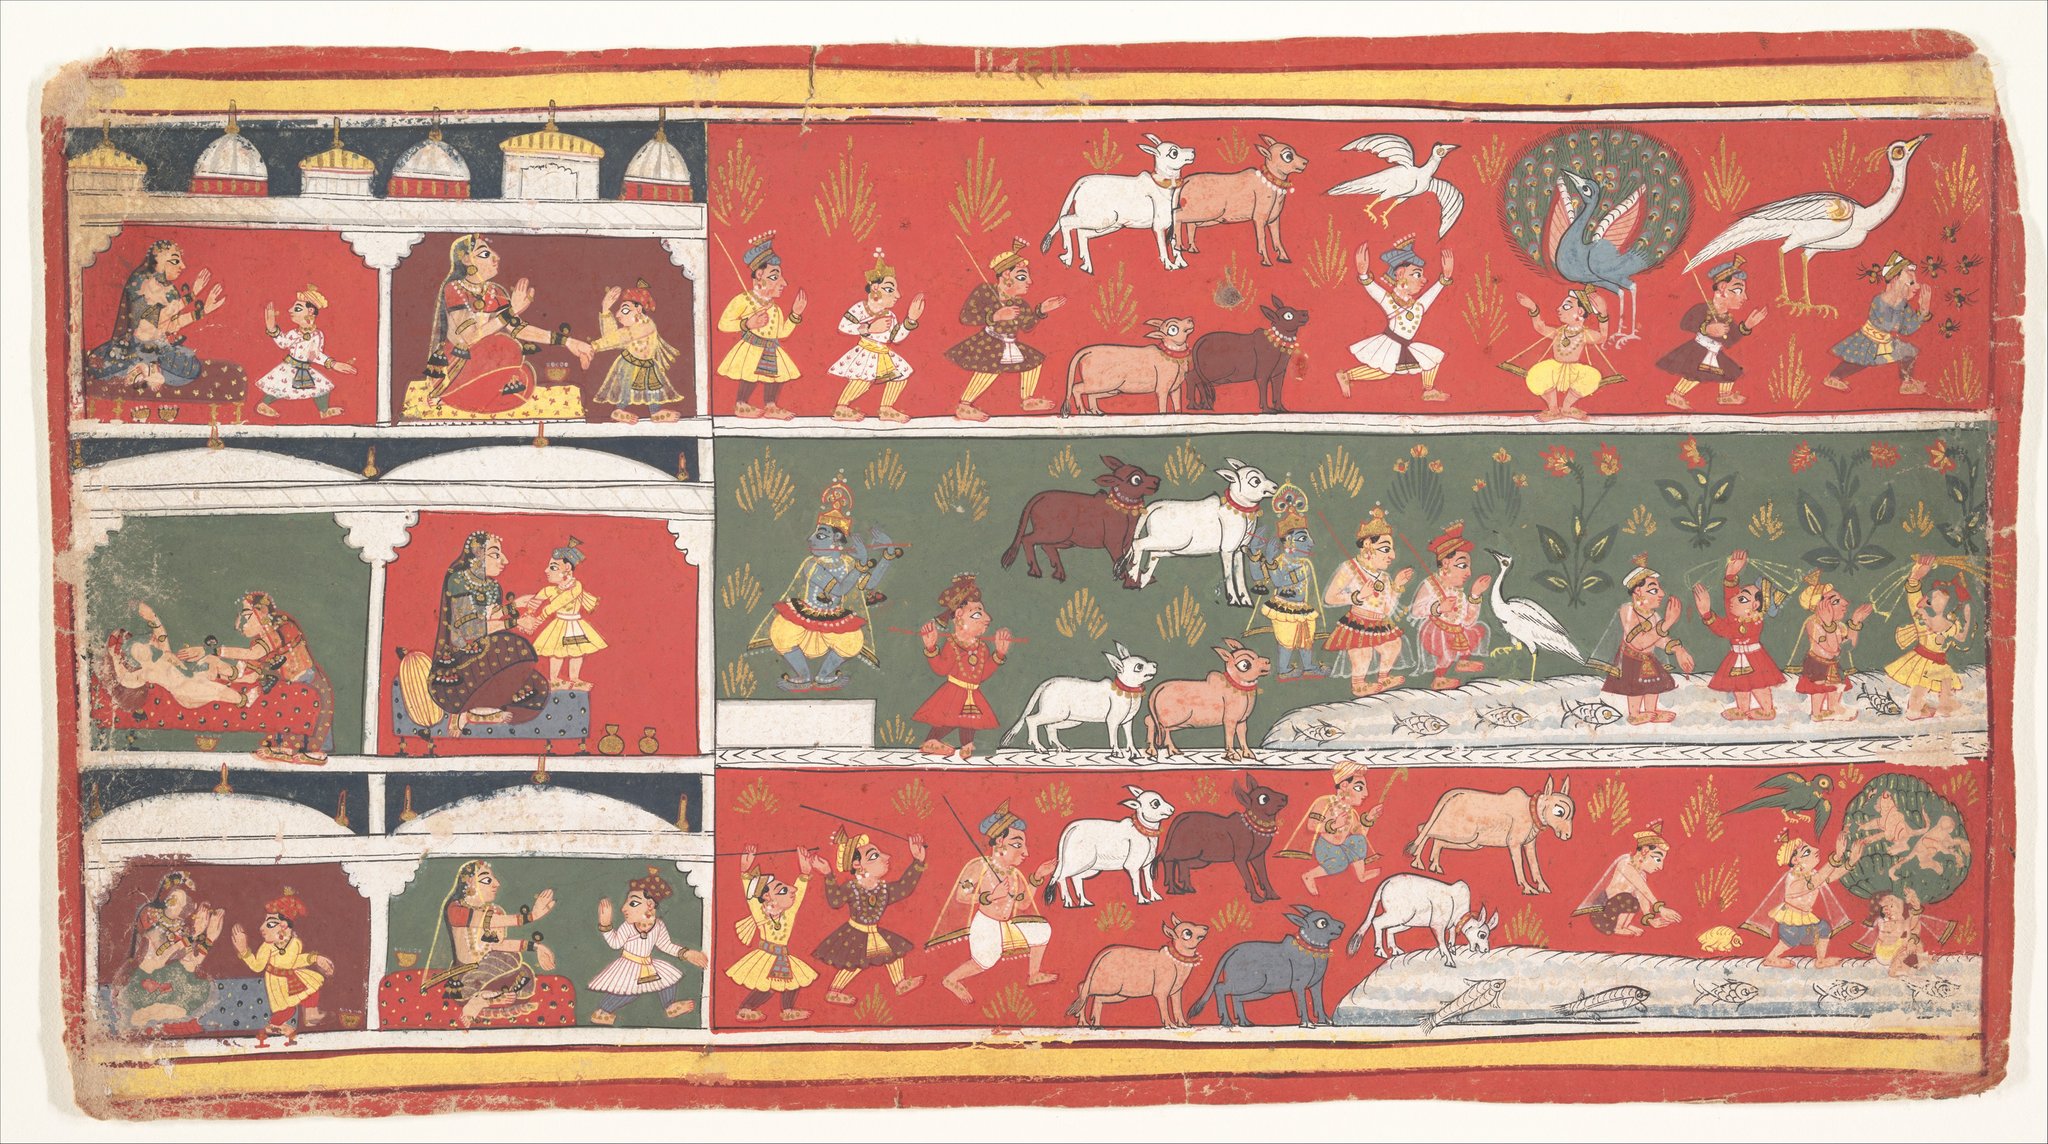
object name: folio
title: Bakasura, the Crane Demon, Arrives in Brindavan: Page from a Dispersed Bhagavata Purana (Ancient Stories of Lord Vishnu)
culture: indian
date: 1700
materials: ink, paper, watercolor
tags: cranes,men,women,cows,demons